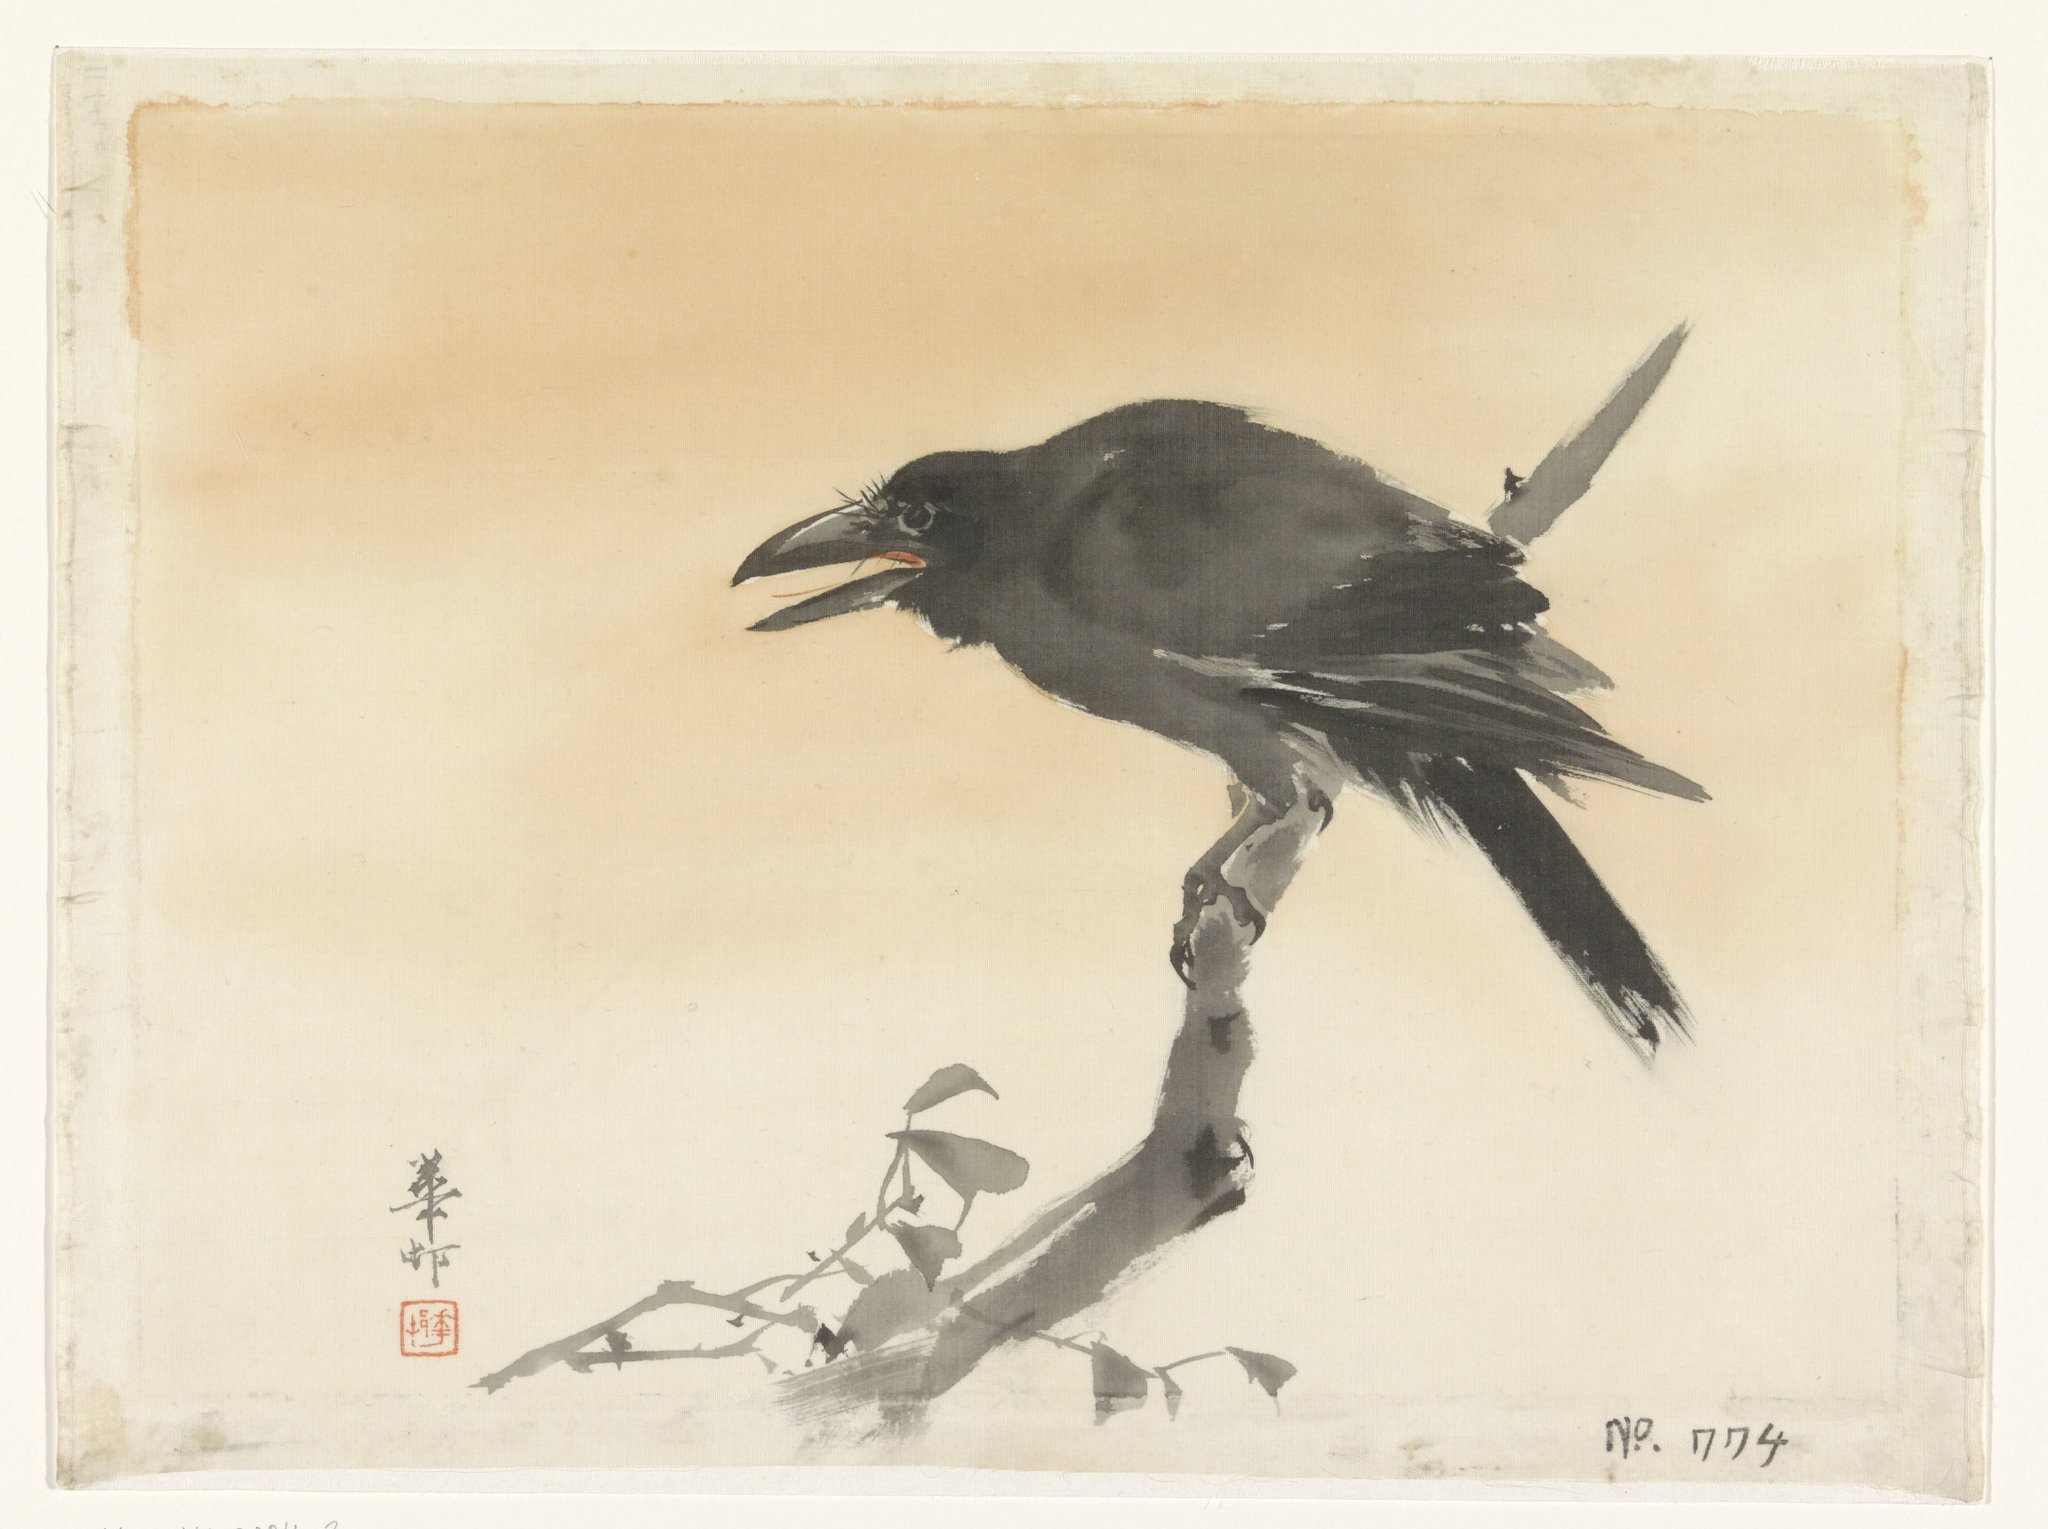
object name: painting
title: Kraai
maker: suzuki kason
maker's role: painter, print maker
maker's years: 1860-1919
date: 1870-1919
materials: paper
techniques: brush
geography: japan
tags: song-birds: crow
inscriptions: seal: ‘Kason’, signature: ‘Kason’